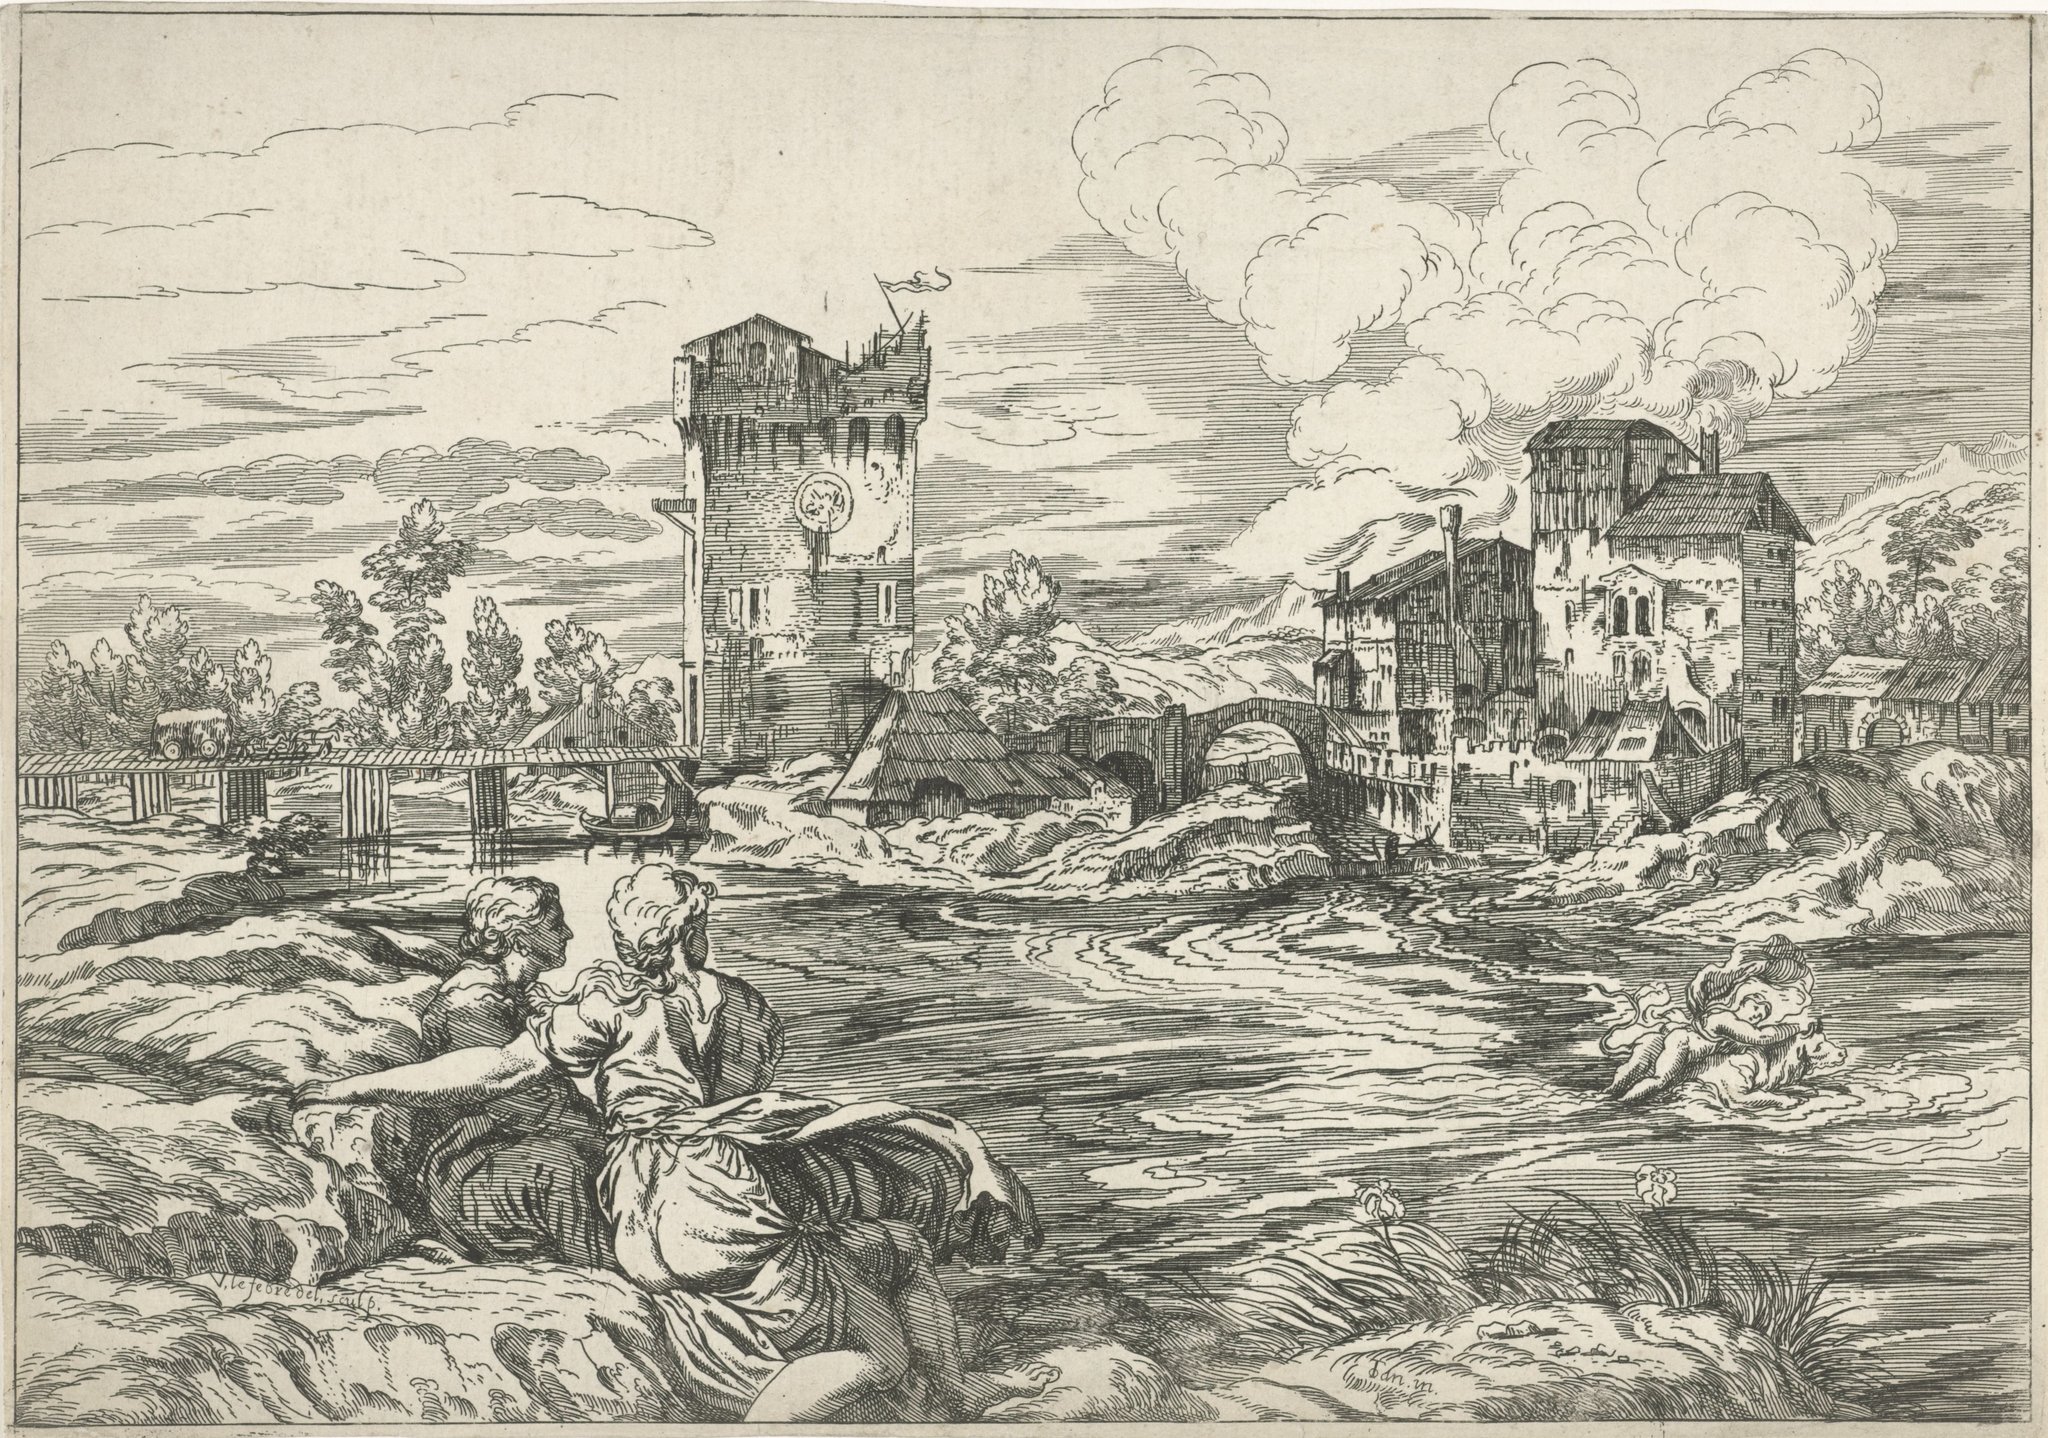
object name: print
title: Opera Selectiora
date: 1680-1749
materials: paper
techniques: etching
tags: jupiter, usually in the shape of a white bull, abducts europa and carries her across the water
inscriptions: collector's mark: Lugt 2228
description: Landschap waarin Europa door Jupiter in de gedaante van een stier wordt weggevoerd over het water. Links op de oever kijken twee dienstmaagden toe. De prent maakt deel uit van een 53-delige serie prenten naar schilderijen van Titiaan en Veronese.